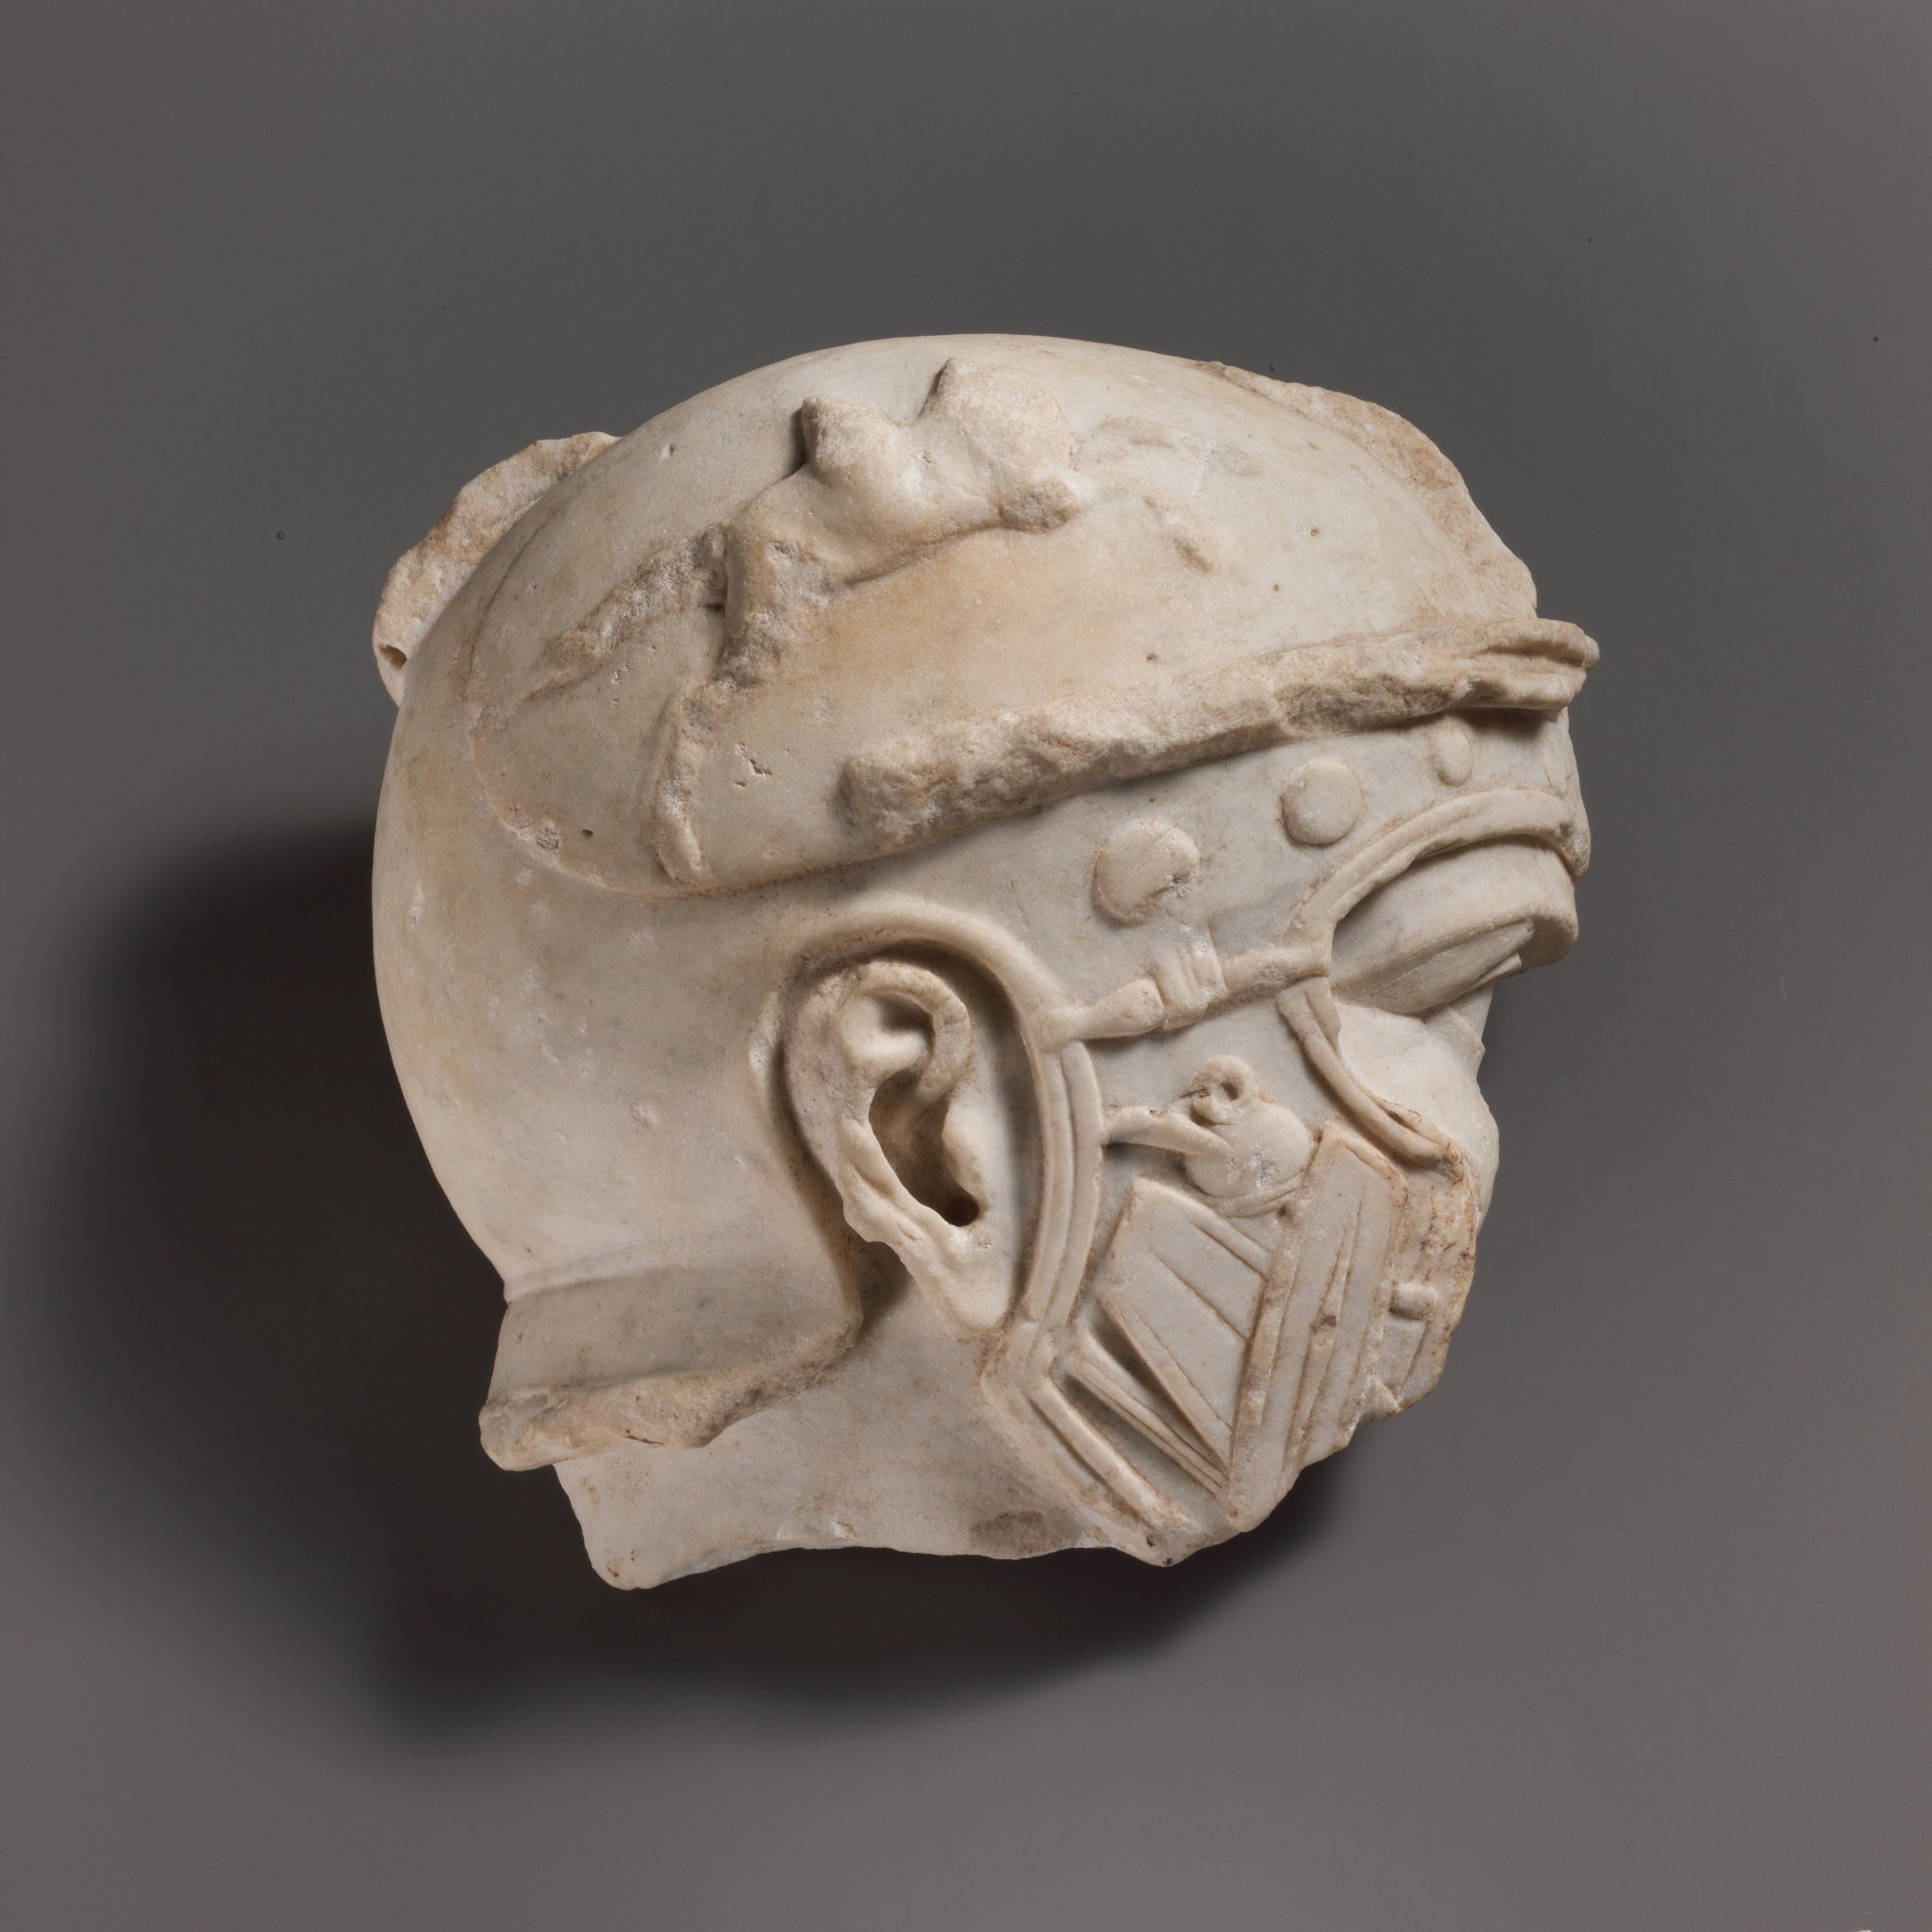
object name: head of a roman soldier with helmet, fragment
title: Fragmentary marble head of a helmeted soldier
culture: roman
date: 69-79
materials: marble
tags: helmets,heads